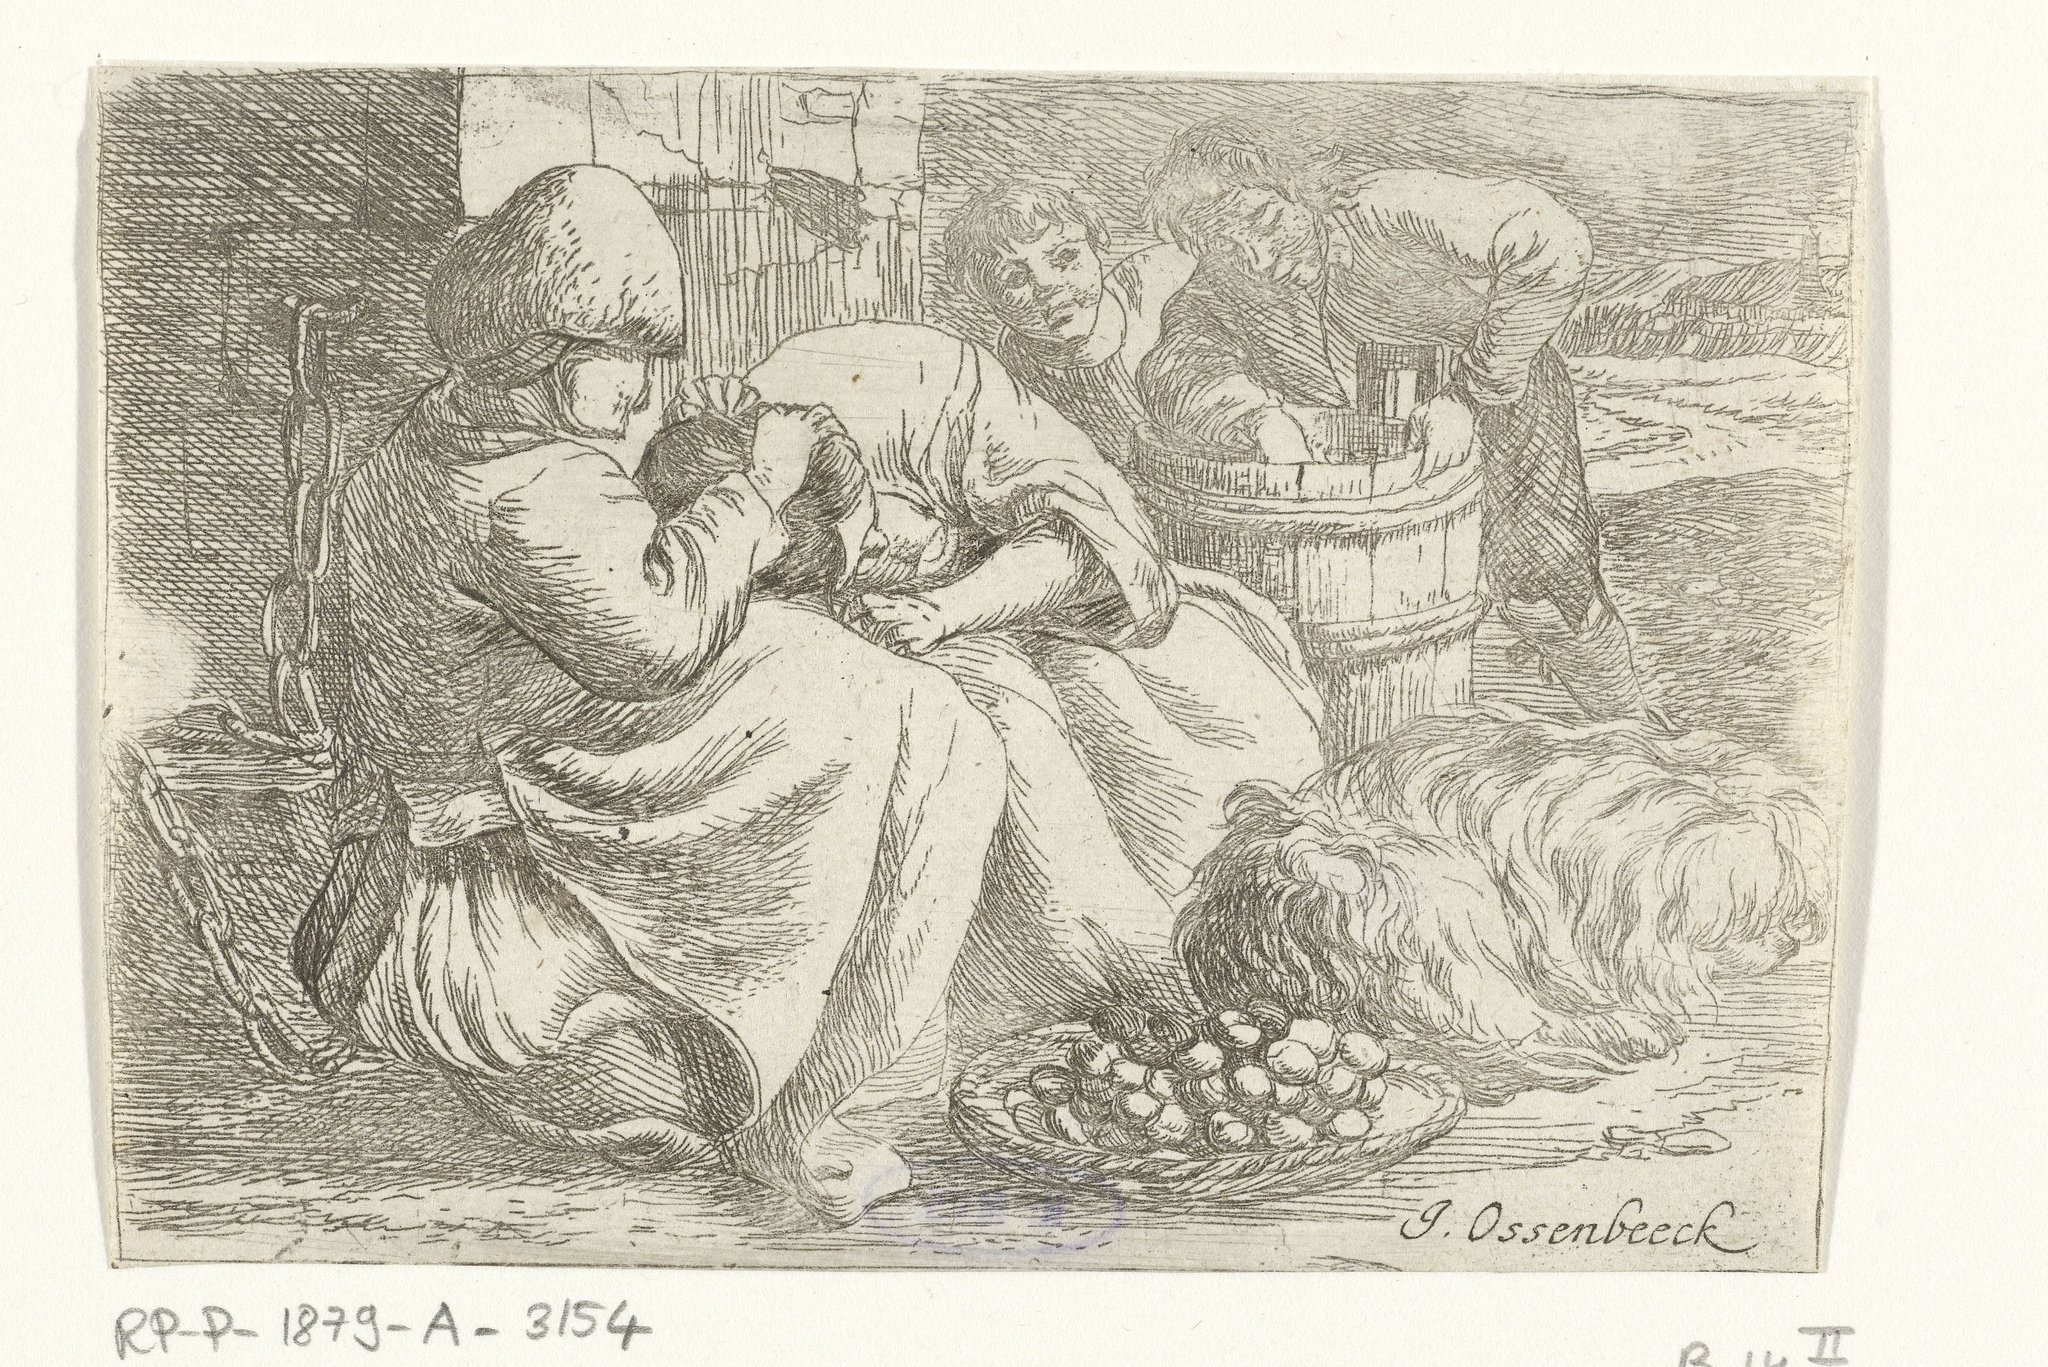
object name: print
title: Oude vrouw ontluist een meisje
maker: jan van ossenbeeck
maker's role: print maker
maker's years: 1623-1674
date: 1647-1674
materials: paper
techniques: etching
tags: 'motherly care', delousing - aa - female human figure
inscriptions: collector's mark: Lugt 2228, collector's mark: Lugt 2610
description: Een oude vrouw zit voor een hut op de grond en ontluist een meisje. Het meisje houdt haar hoofd in de schoot van de oude vrouw. Erachter twee jongens bij een vat. Op de grond een hond bij een schaal met schelpen.